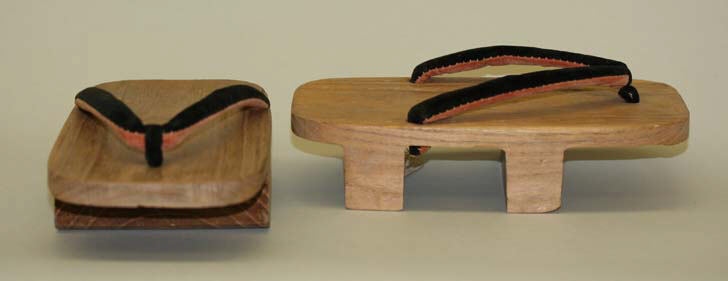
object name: shoe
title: Shoes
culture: japanese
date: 1800-1941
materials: wood